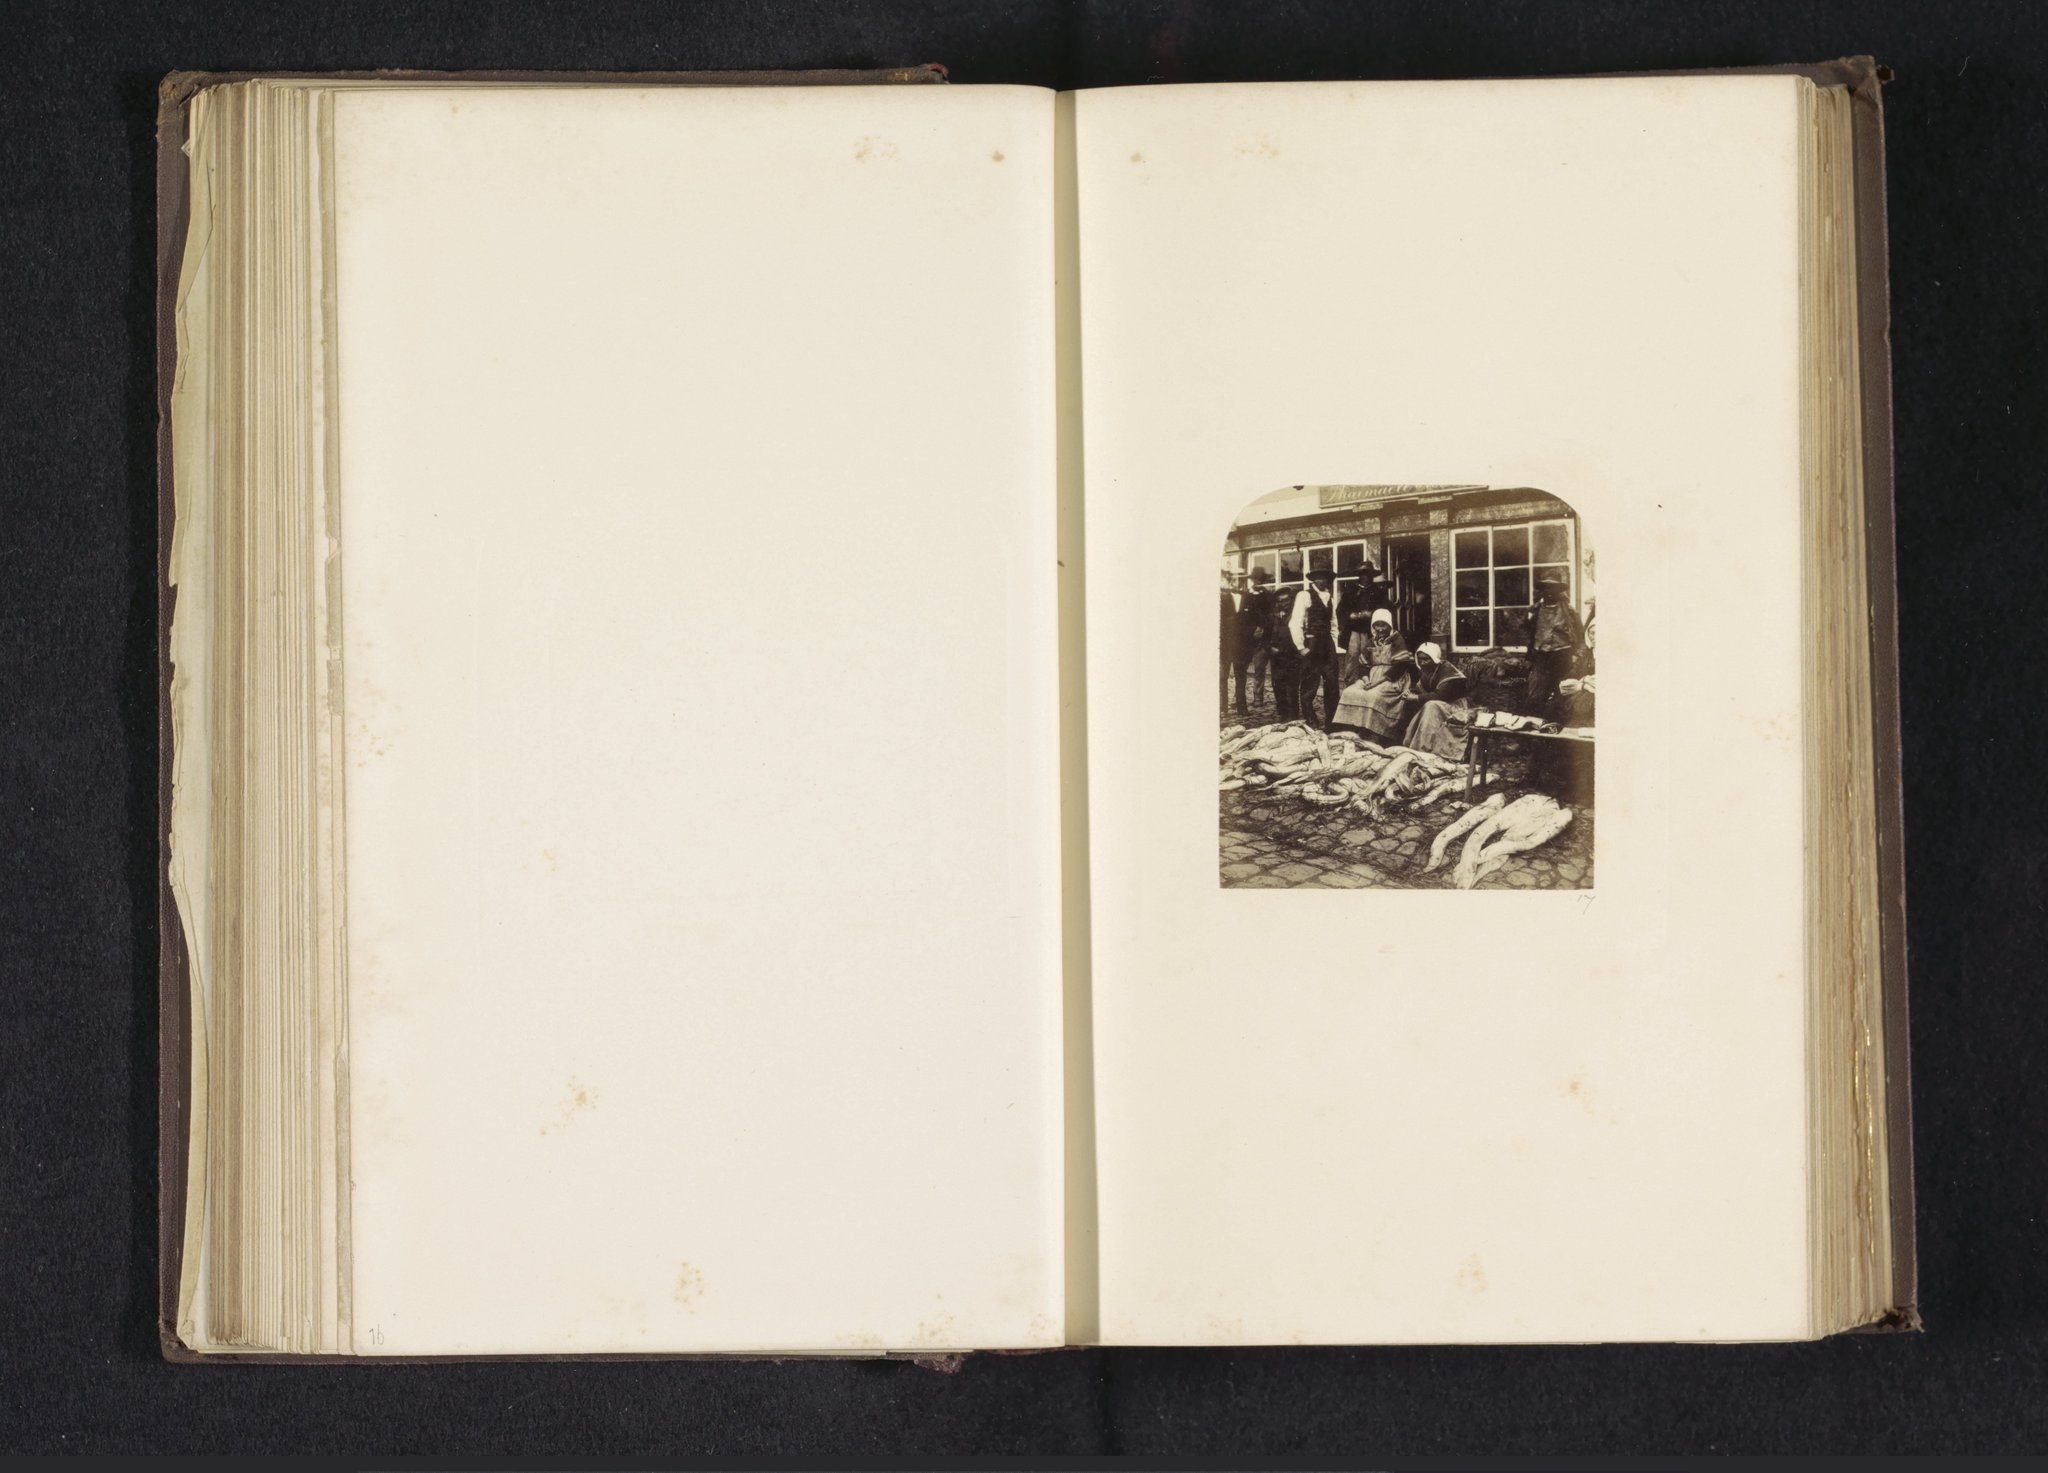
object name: photograph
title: Visvrouwen verkopen zeepaling op de markt in Lannion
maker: taylor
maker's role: fotograaf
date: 1850-1859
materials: photographic support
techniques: albumen print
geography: lannion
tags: stall, booth (~ market), market, working class, labourers - aa - women, eels: sea-eel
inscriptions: number: ‘17’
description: Foto op derde ongenummerde pagina na pagina 88.